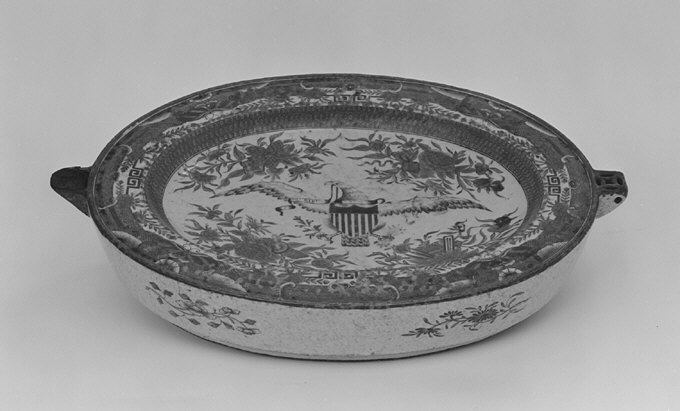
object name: hot water plate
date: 1801-1833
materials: hard paste porcelain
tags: coat of arms